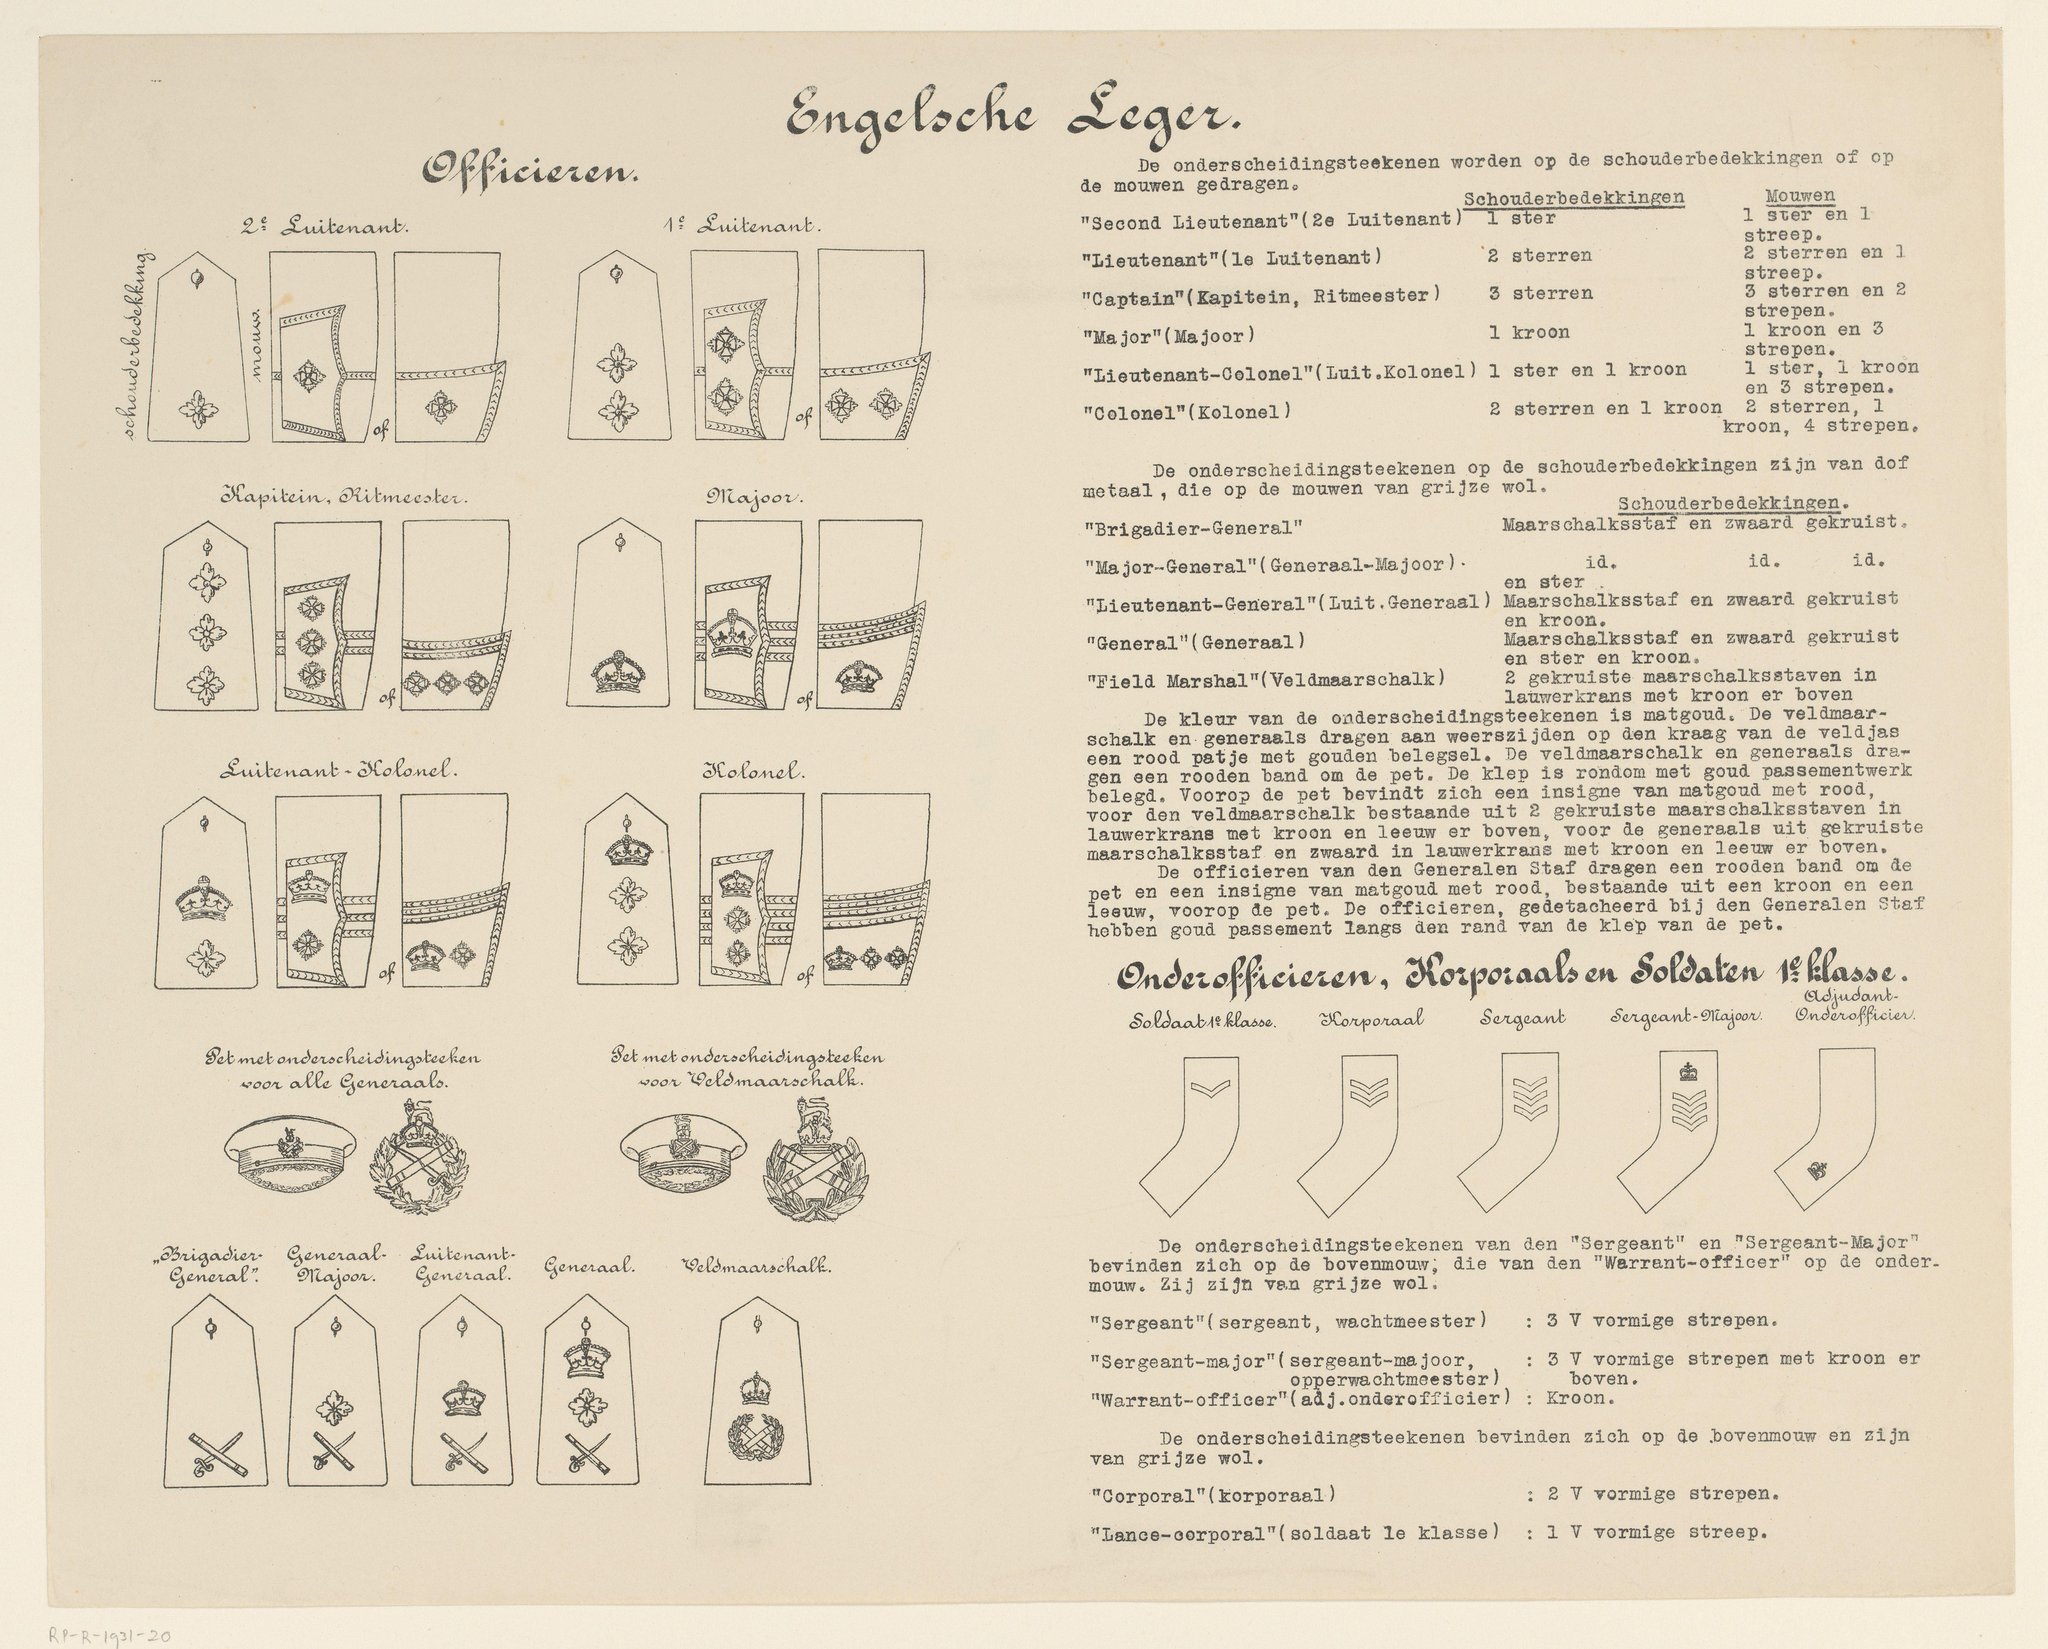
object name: print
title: Engelsche Leger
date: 1914-1918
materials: paper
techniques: autotype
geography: netherlands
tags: (military) uniforms, great britain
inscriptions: collector's mark: Lugt 2228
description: Overzicht van de onderscheidingstekenen op de uniformen van het Britse leger tijdens de Eerste Wereldoorlog.